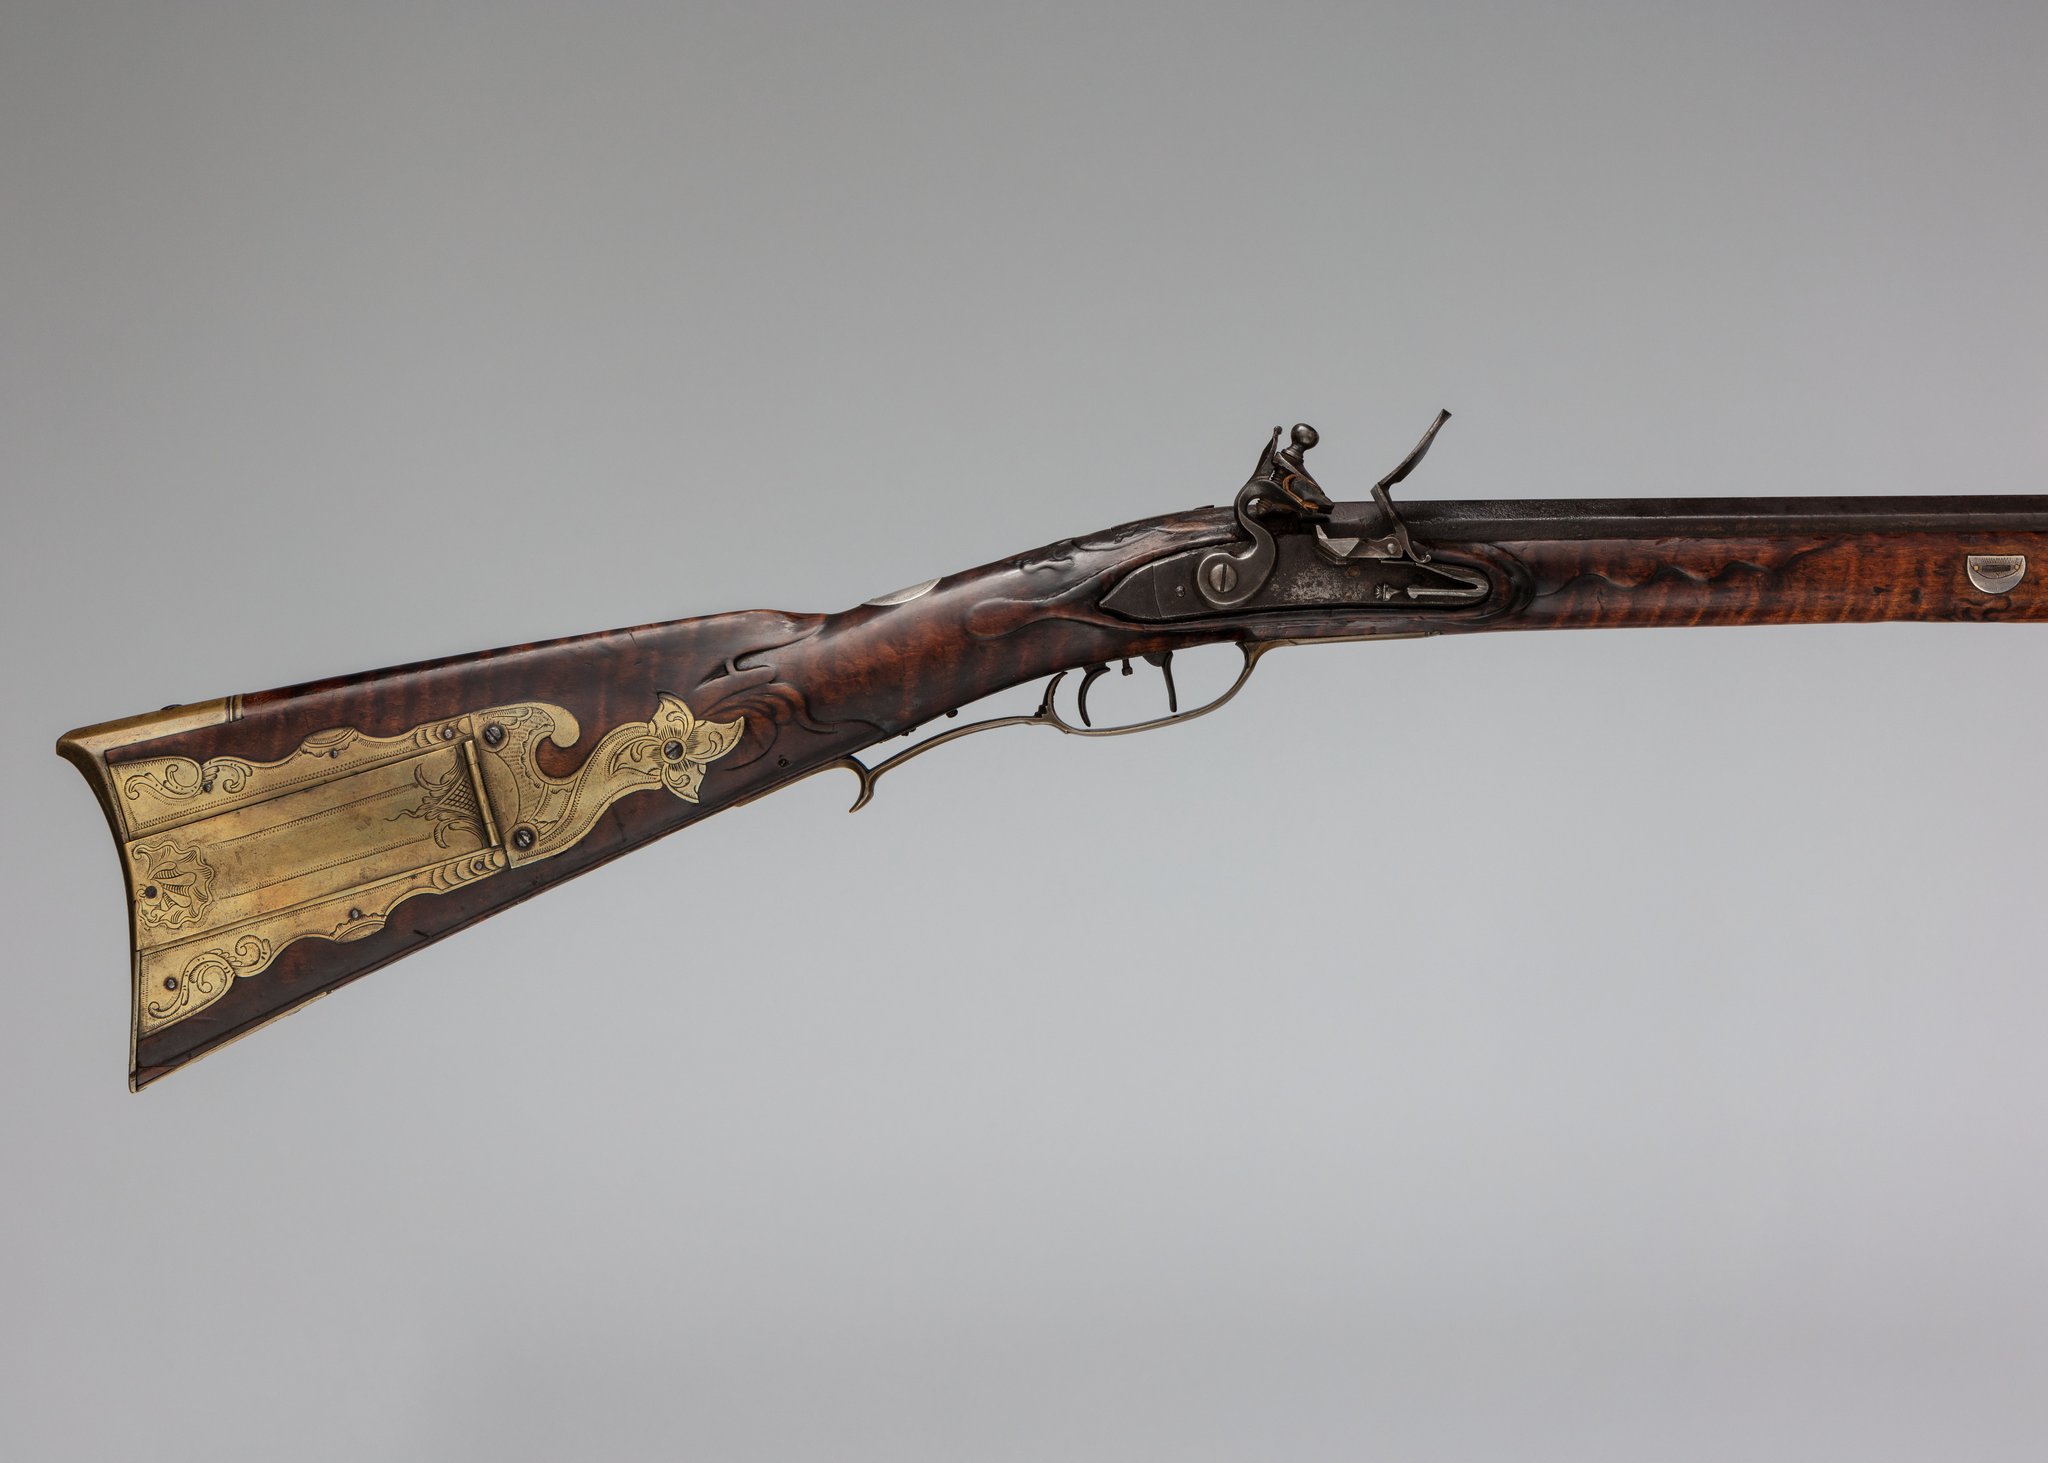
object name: flintlock longrifle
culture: american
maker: george schreyer, sr.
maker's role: gunsmith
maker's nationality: american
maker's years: 1739-1819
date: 1795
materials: brass, iron, silver, steel, wood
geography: united states